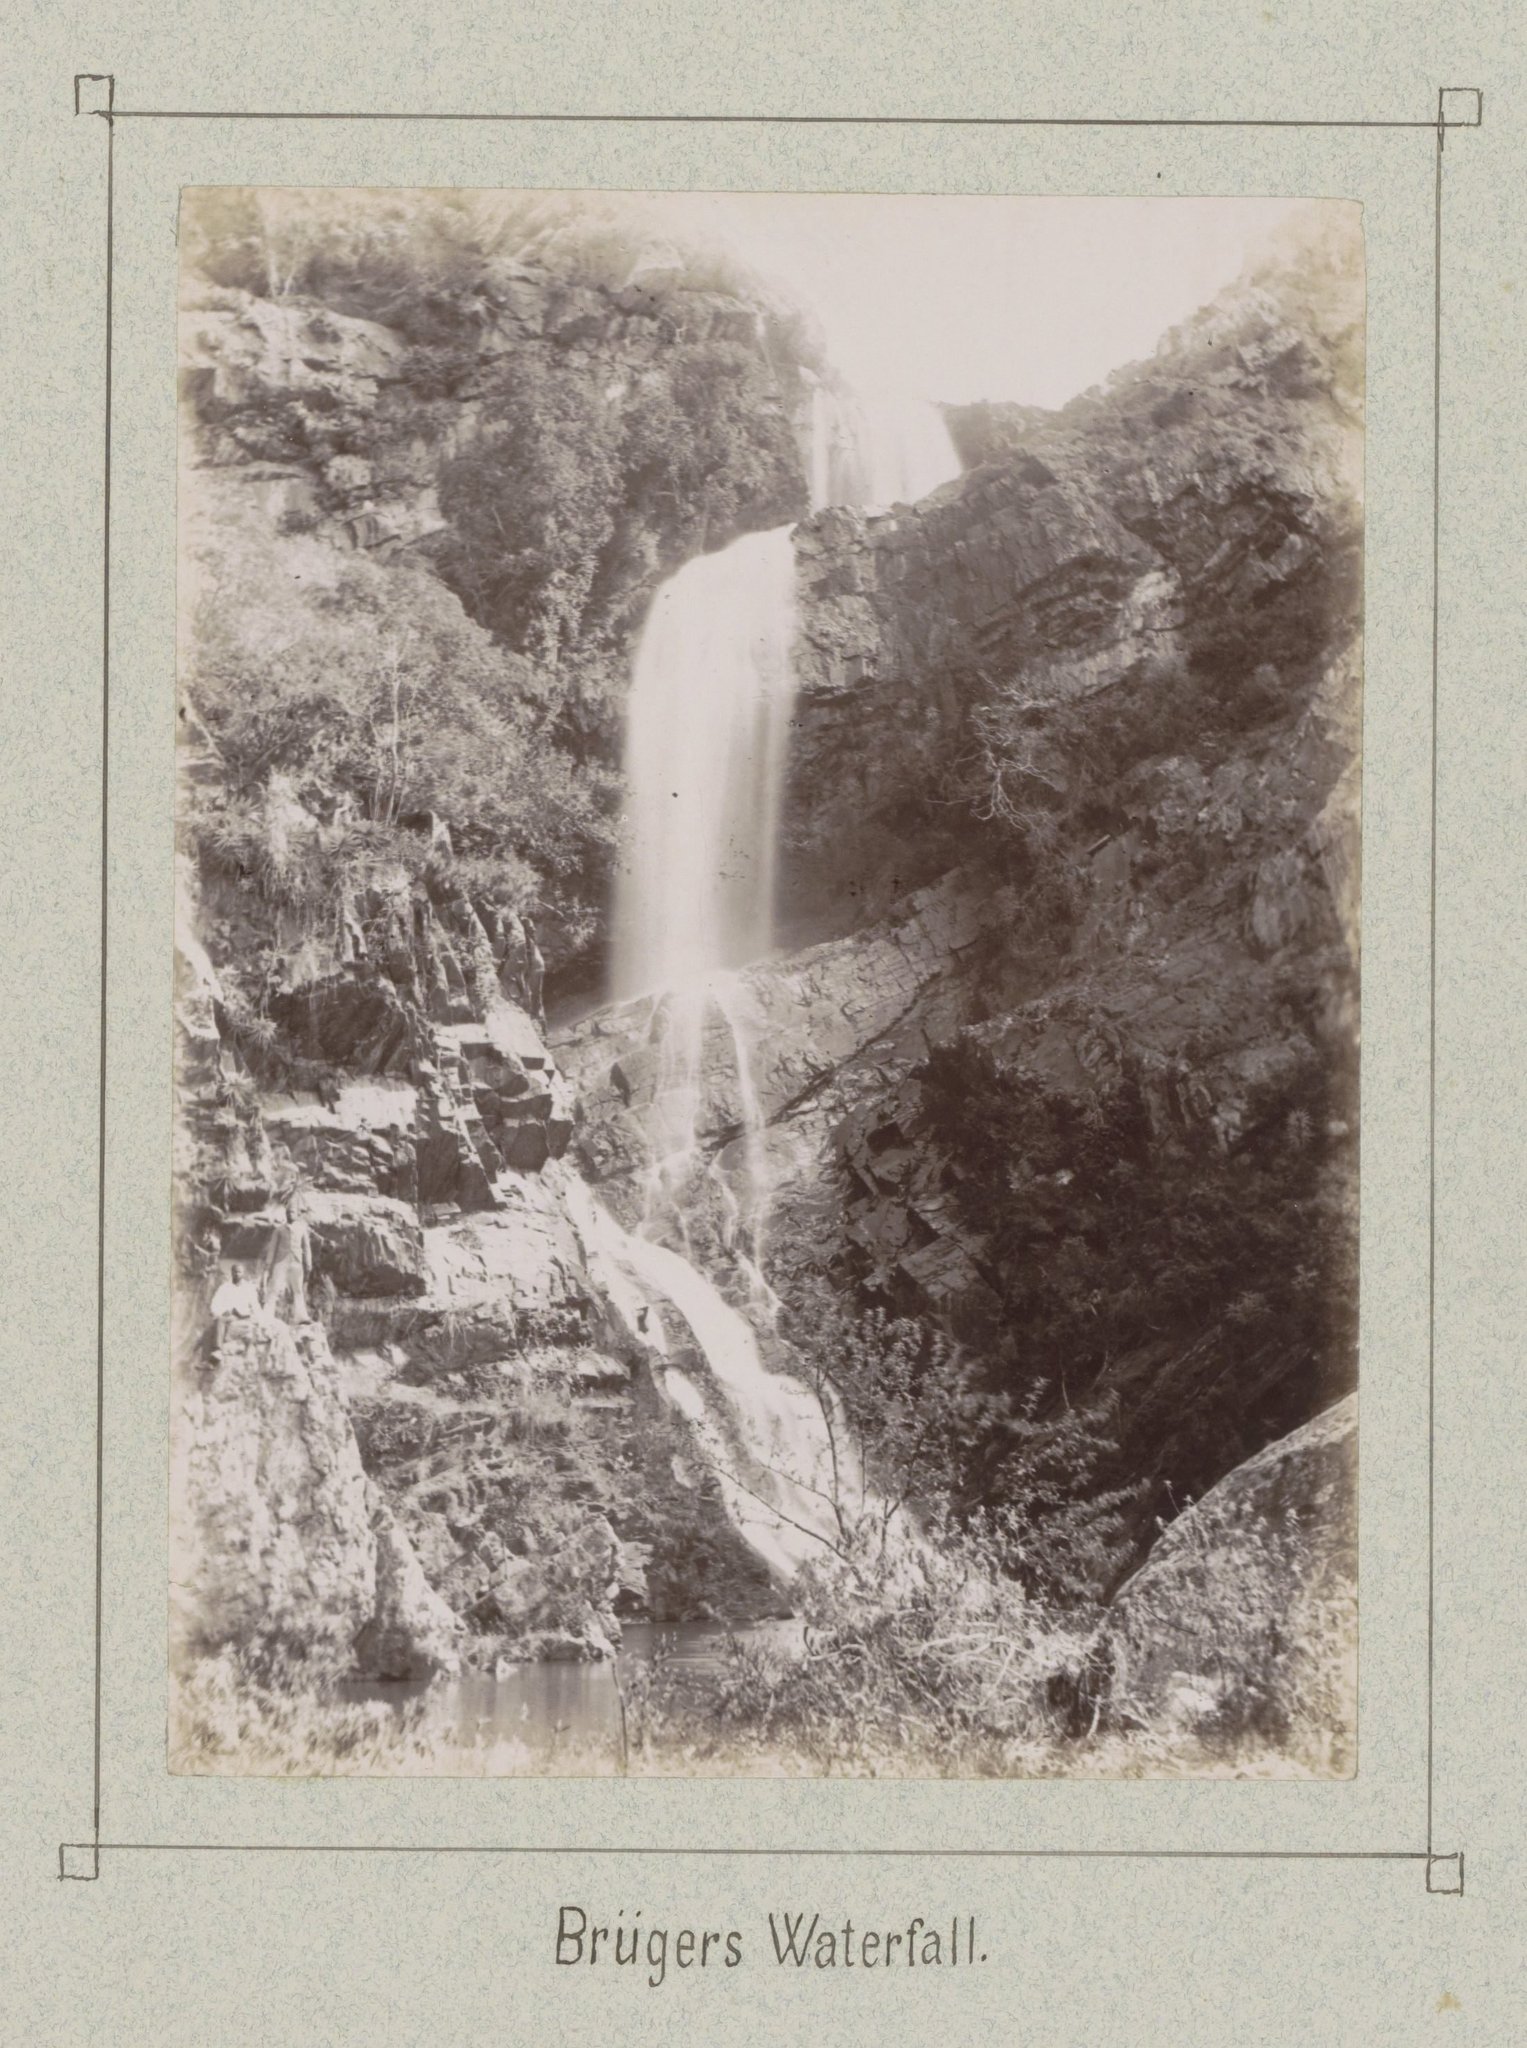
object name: photograph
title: Waterval in Zuid-Afrika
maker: Anonymous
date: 1880-1900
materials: photographic support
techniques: albumen print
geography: south africa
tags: waterfall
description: Onderdeel van Reisalbum met foto's van Zuid-Afrika, Madeira, Portugal, Frankrijk en Duitsland.